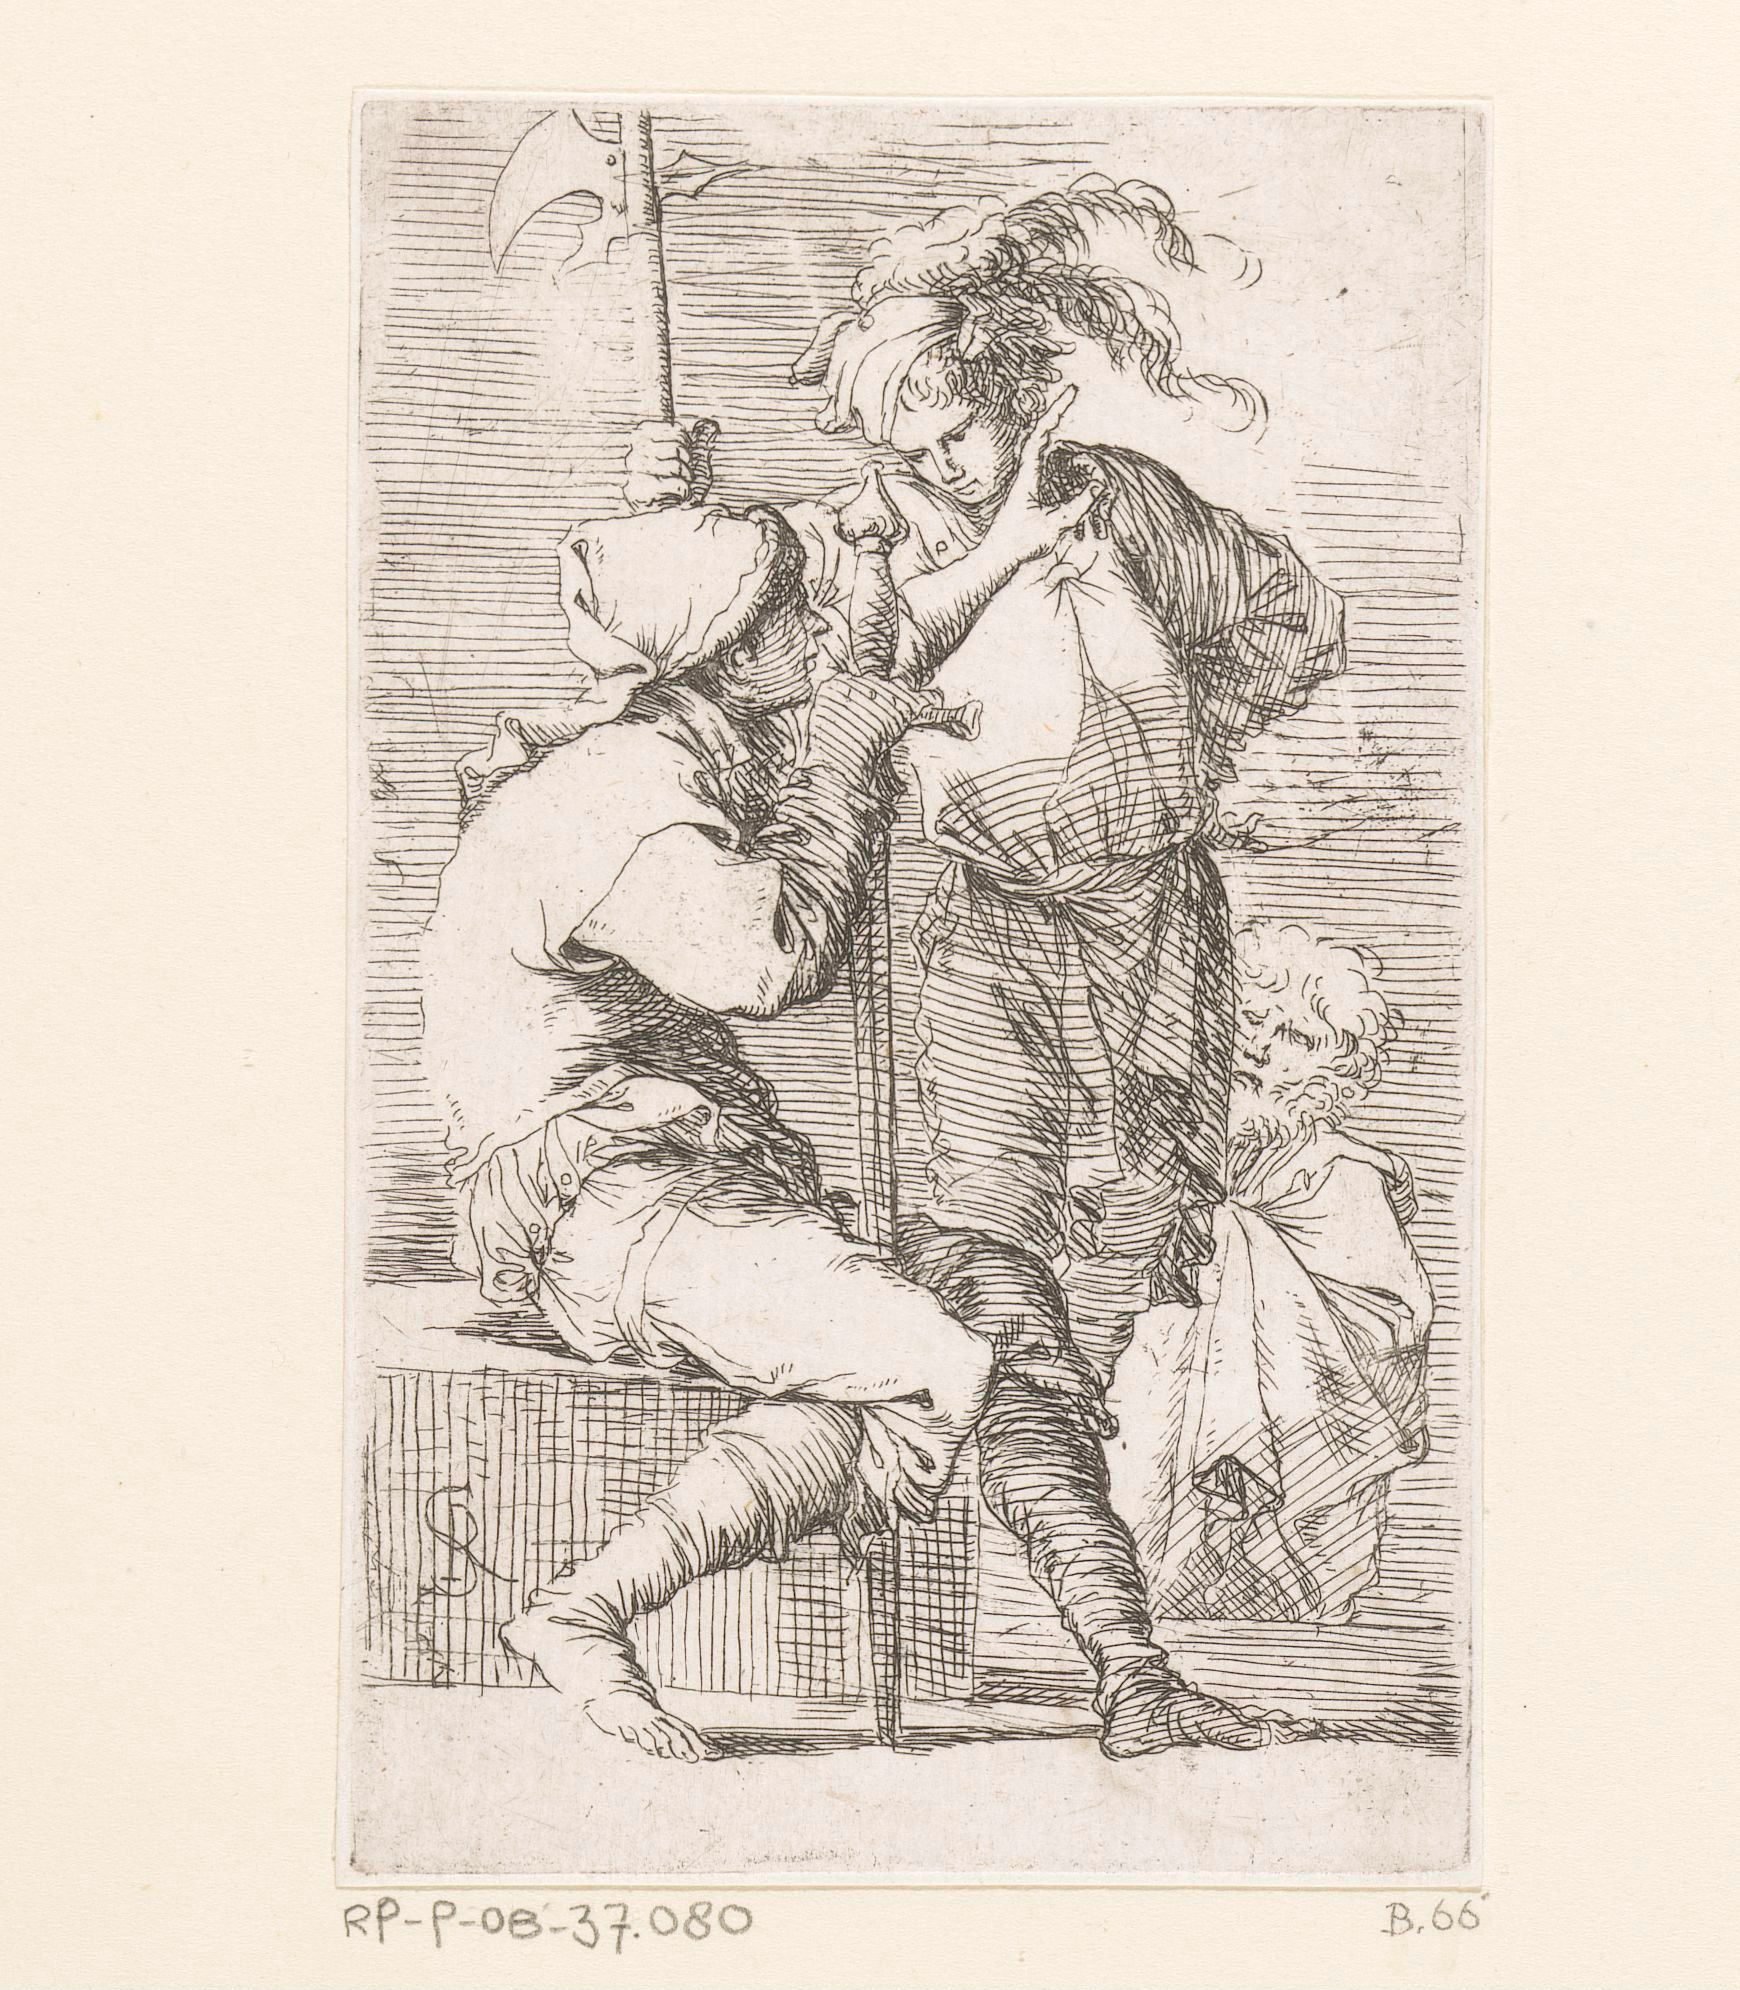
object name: print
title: Drie soldaten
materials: paper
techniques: etching, intaglio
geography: italy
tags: the soldier; the soldier's life, index finger forwards, pointing, indicating, helved weapons, polearms (for striking, hacking, thrusting): halberd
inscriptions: collector's mark: Lugt 240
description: Door Bartsch wordt deze prent toegeschreven aan Salvator Rosa, terwijl Wallace meent dat het een kopie betreft naar een spiegelbeeldige prent door Rosa (Wallace 65). Naar een tekening die zich eens bevond in de collectie van Ladislao Odescalchi te Rome en in 1974 werd geveild te Berlijn. De tekening is in dezelfde richting als deze prent en spiegelbeeldig aan Wallace 65. De originele prent maakt deel uit van de serie 'Figurine', bestaande uit een titelprent en 80 prenten van klein formaat met voorstellingen van mannelijke en vrouwelijke figuren. Rosa produceerde de serie waarschijnlijk gedurende de jaren 1656 en 1657.